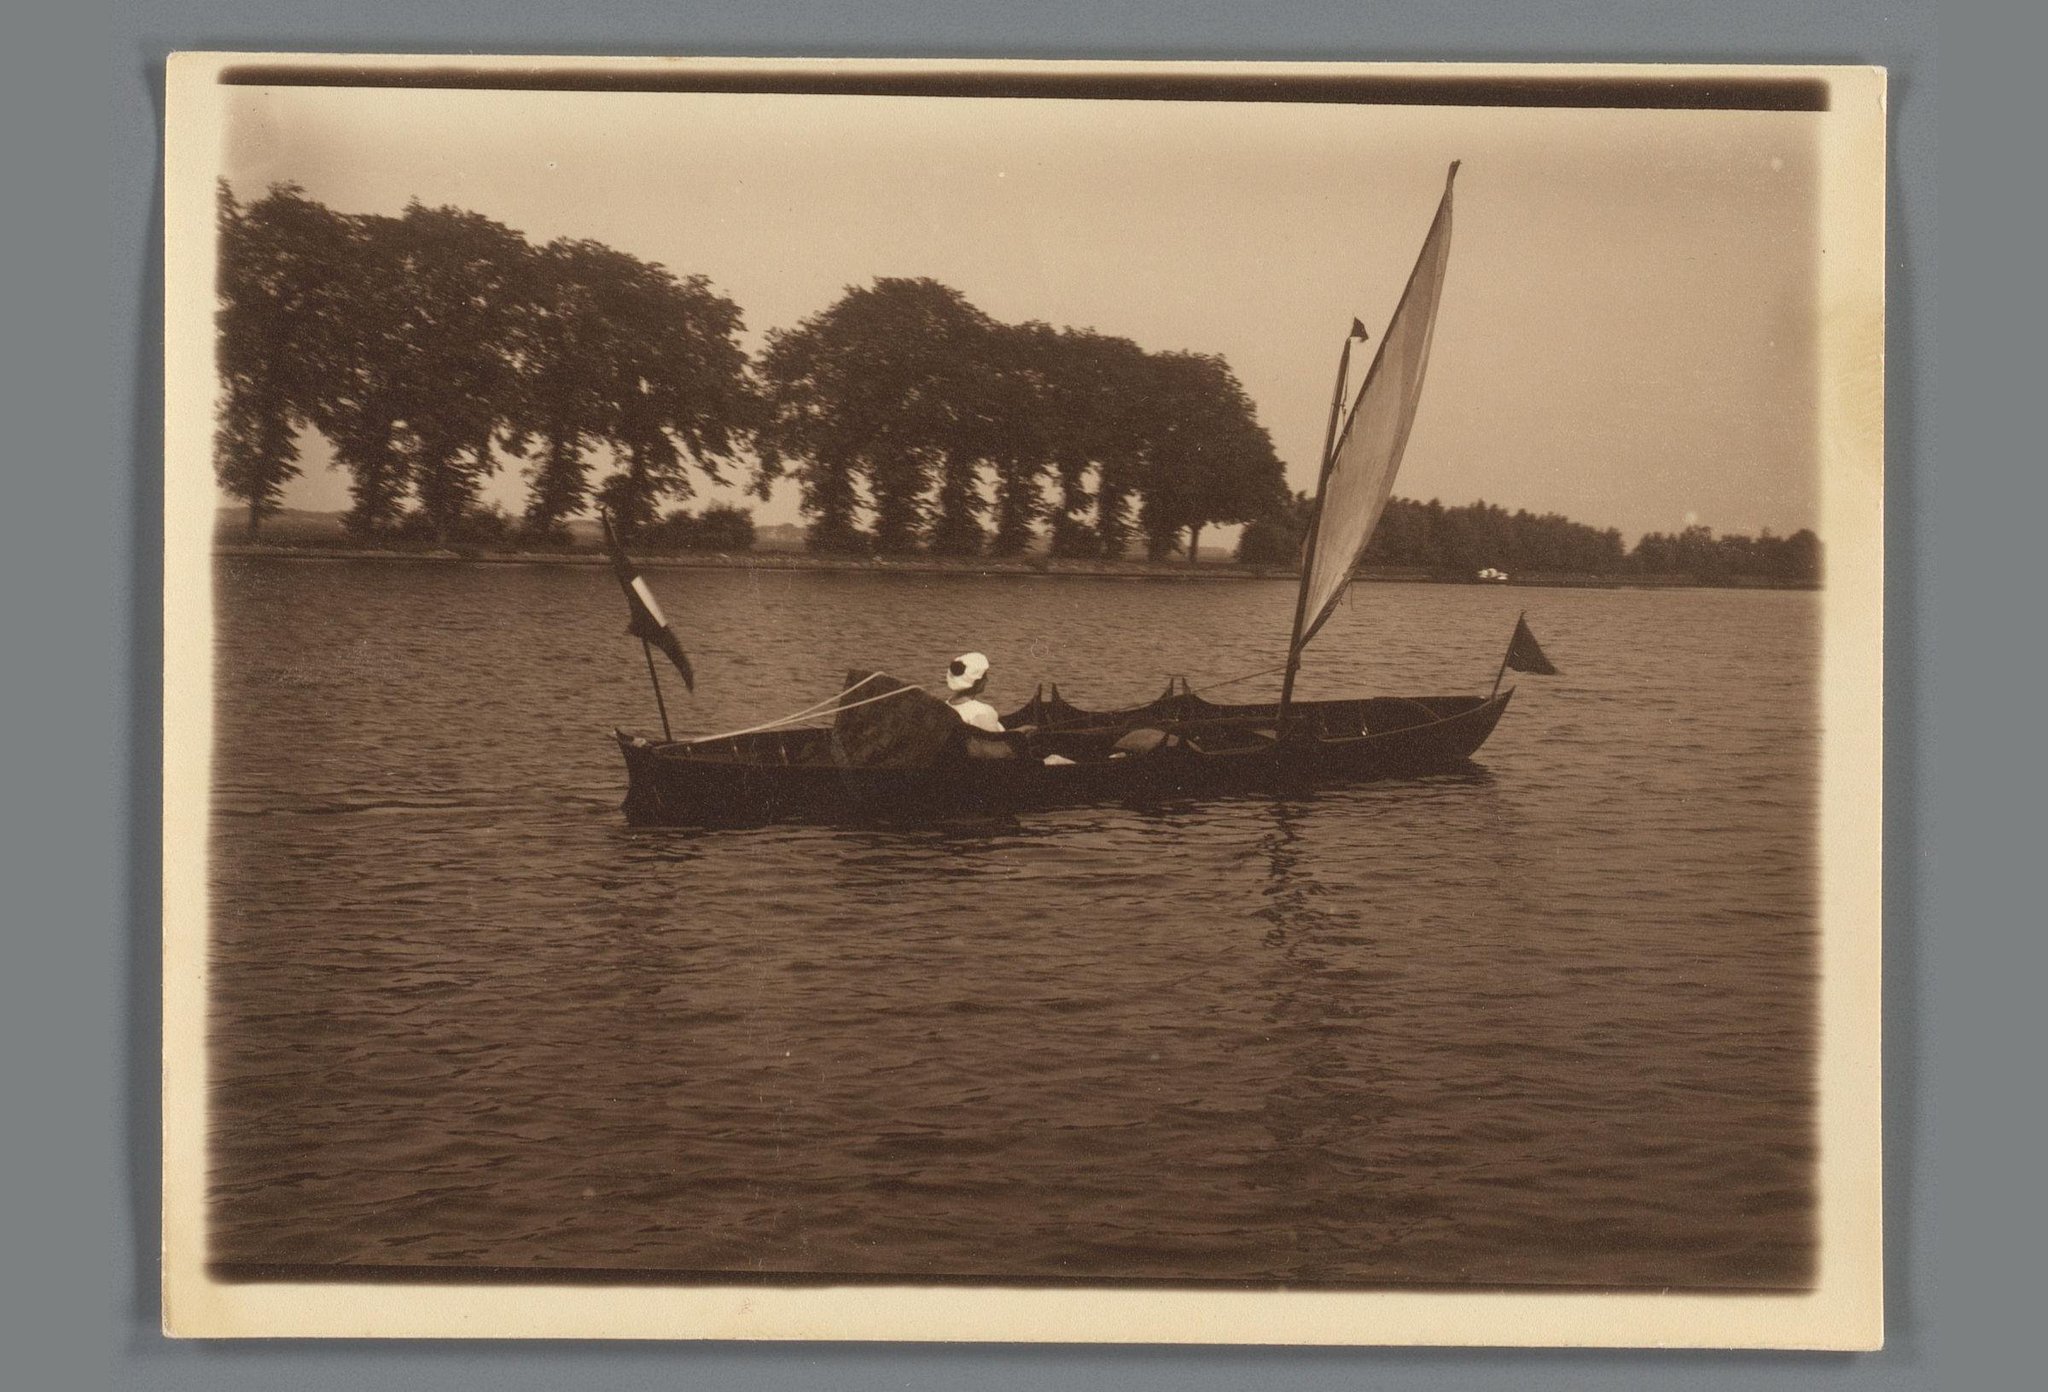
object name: photograph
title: Zeilboot op de Amstel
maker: Anonymous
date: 1916-1918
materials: paper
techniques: matte daylight collodion silver print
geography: amstel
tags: sailing-ship, sailing-boat, river